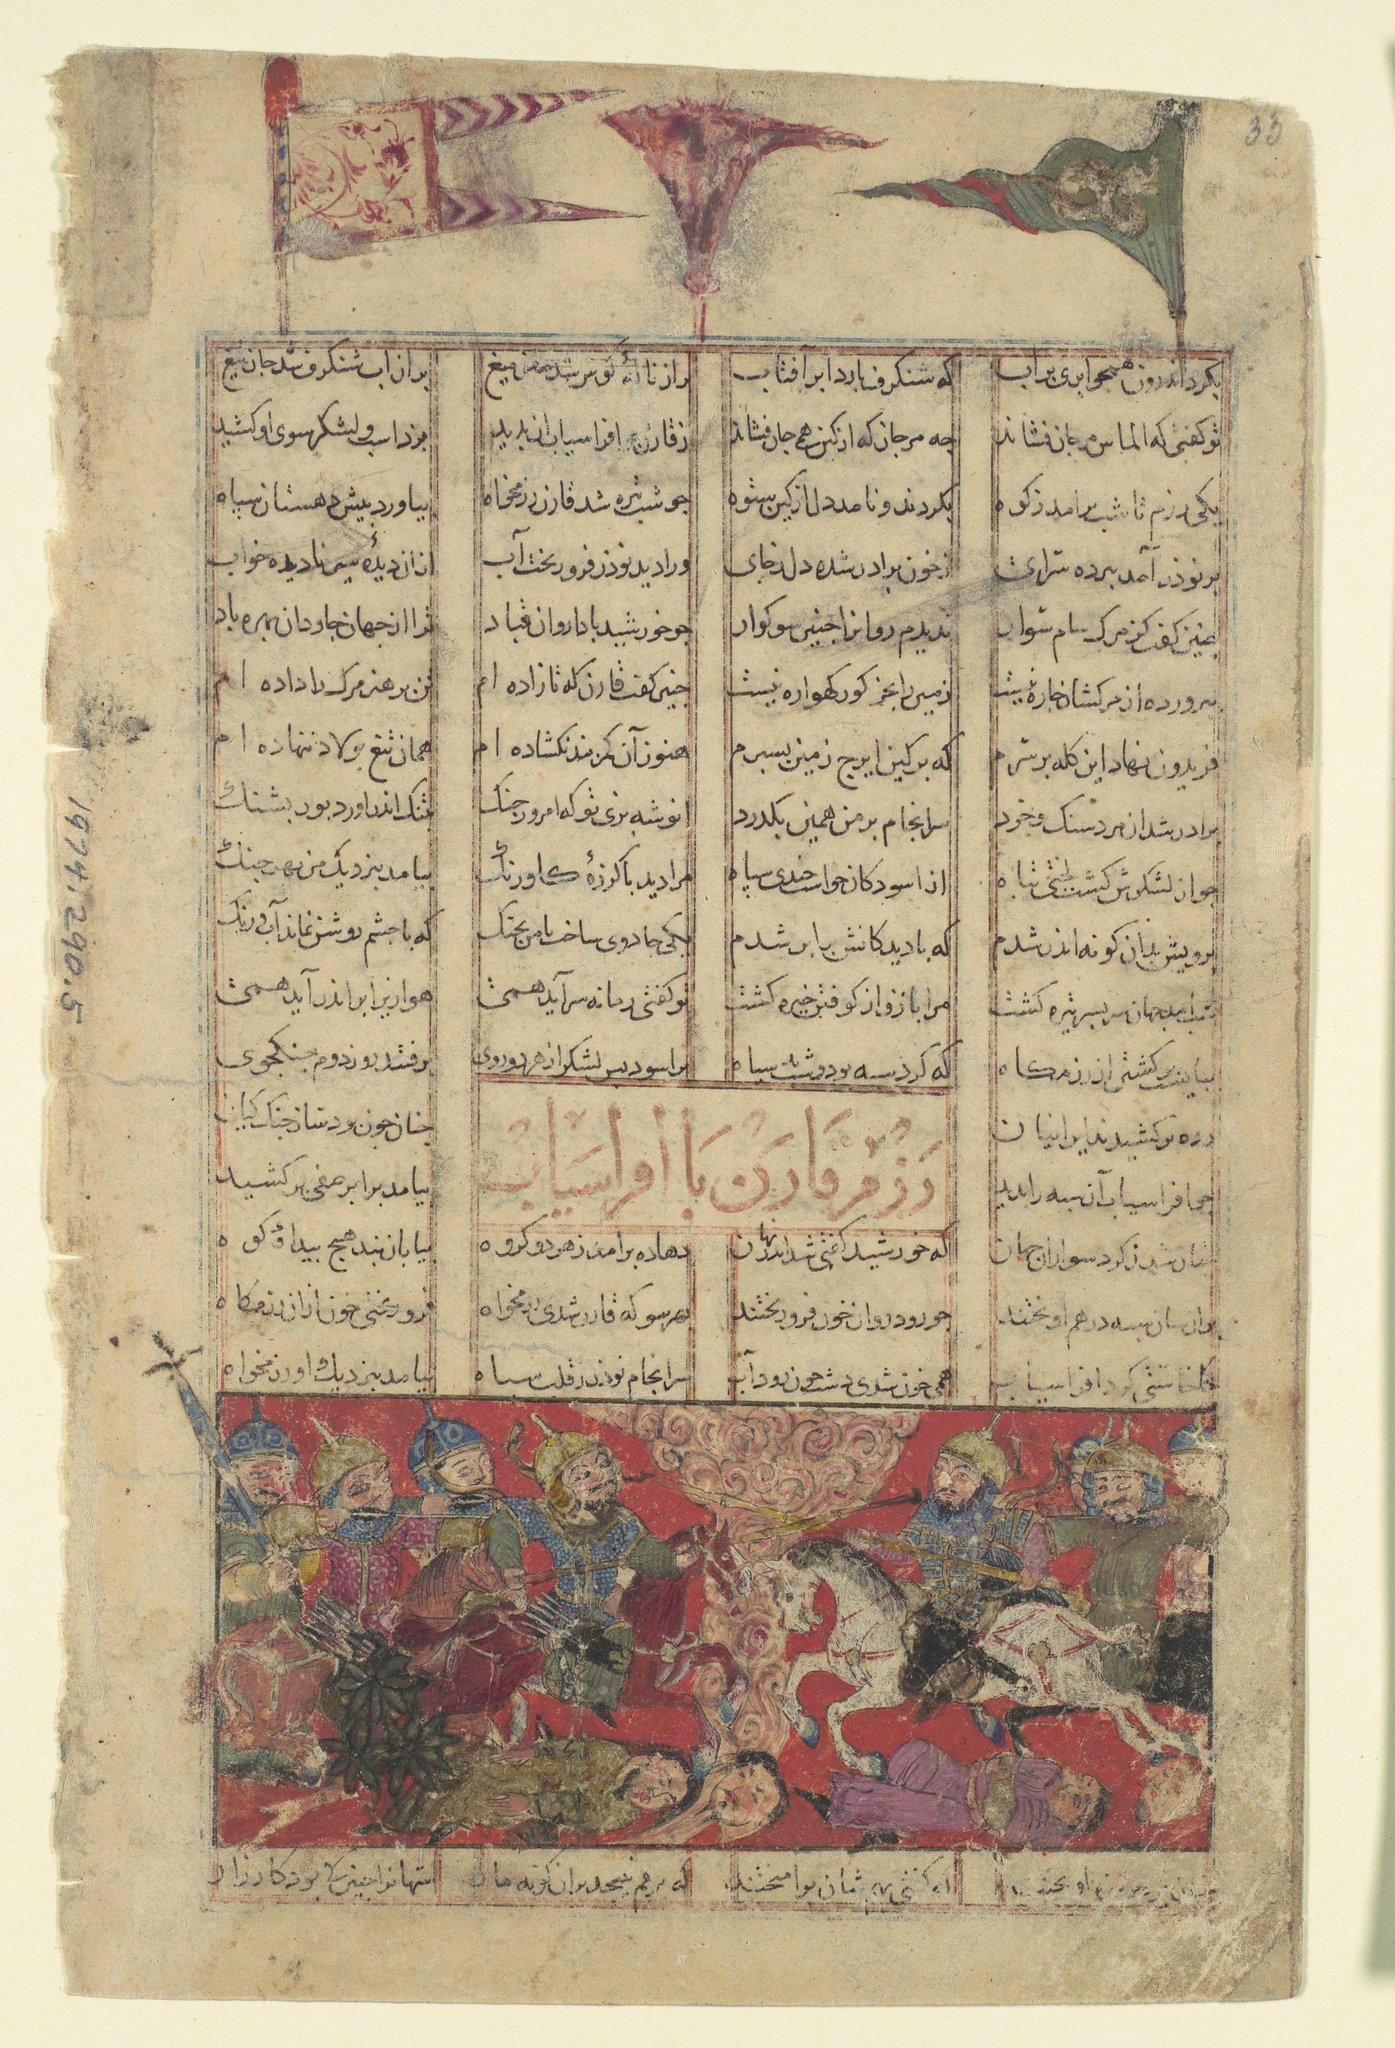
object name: folio from an illustrated manuscript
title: "The Combat of Qaran and Afrasiyab", Folio from a Shahnama (Book of Kings)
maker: abu'l qasim firdausi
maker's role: author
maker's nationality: iranian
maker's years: 935-1020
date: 1330-1340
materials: gold, ink, paper, silver, watercolor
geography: iran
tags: poetry,battles,men,horses